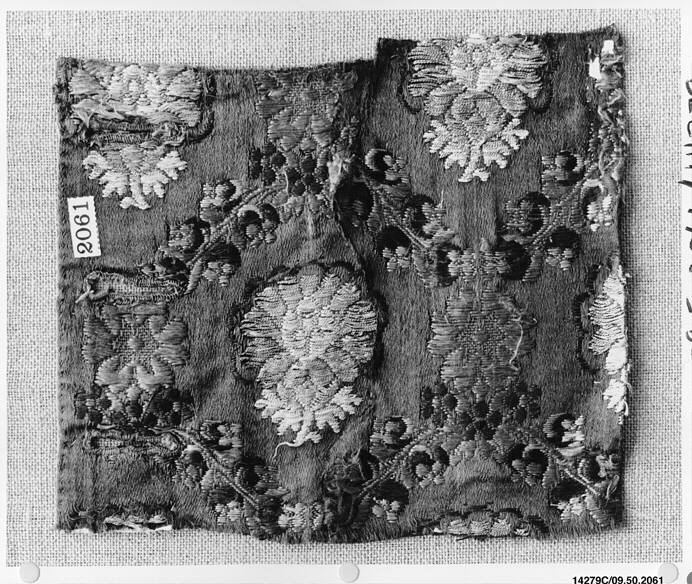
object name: piece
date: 1801-1900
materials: metal thread, silk